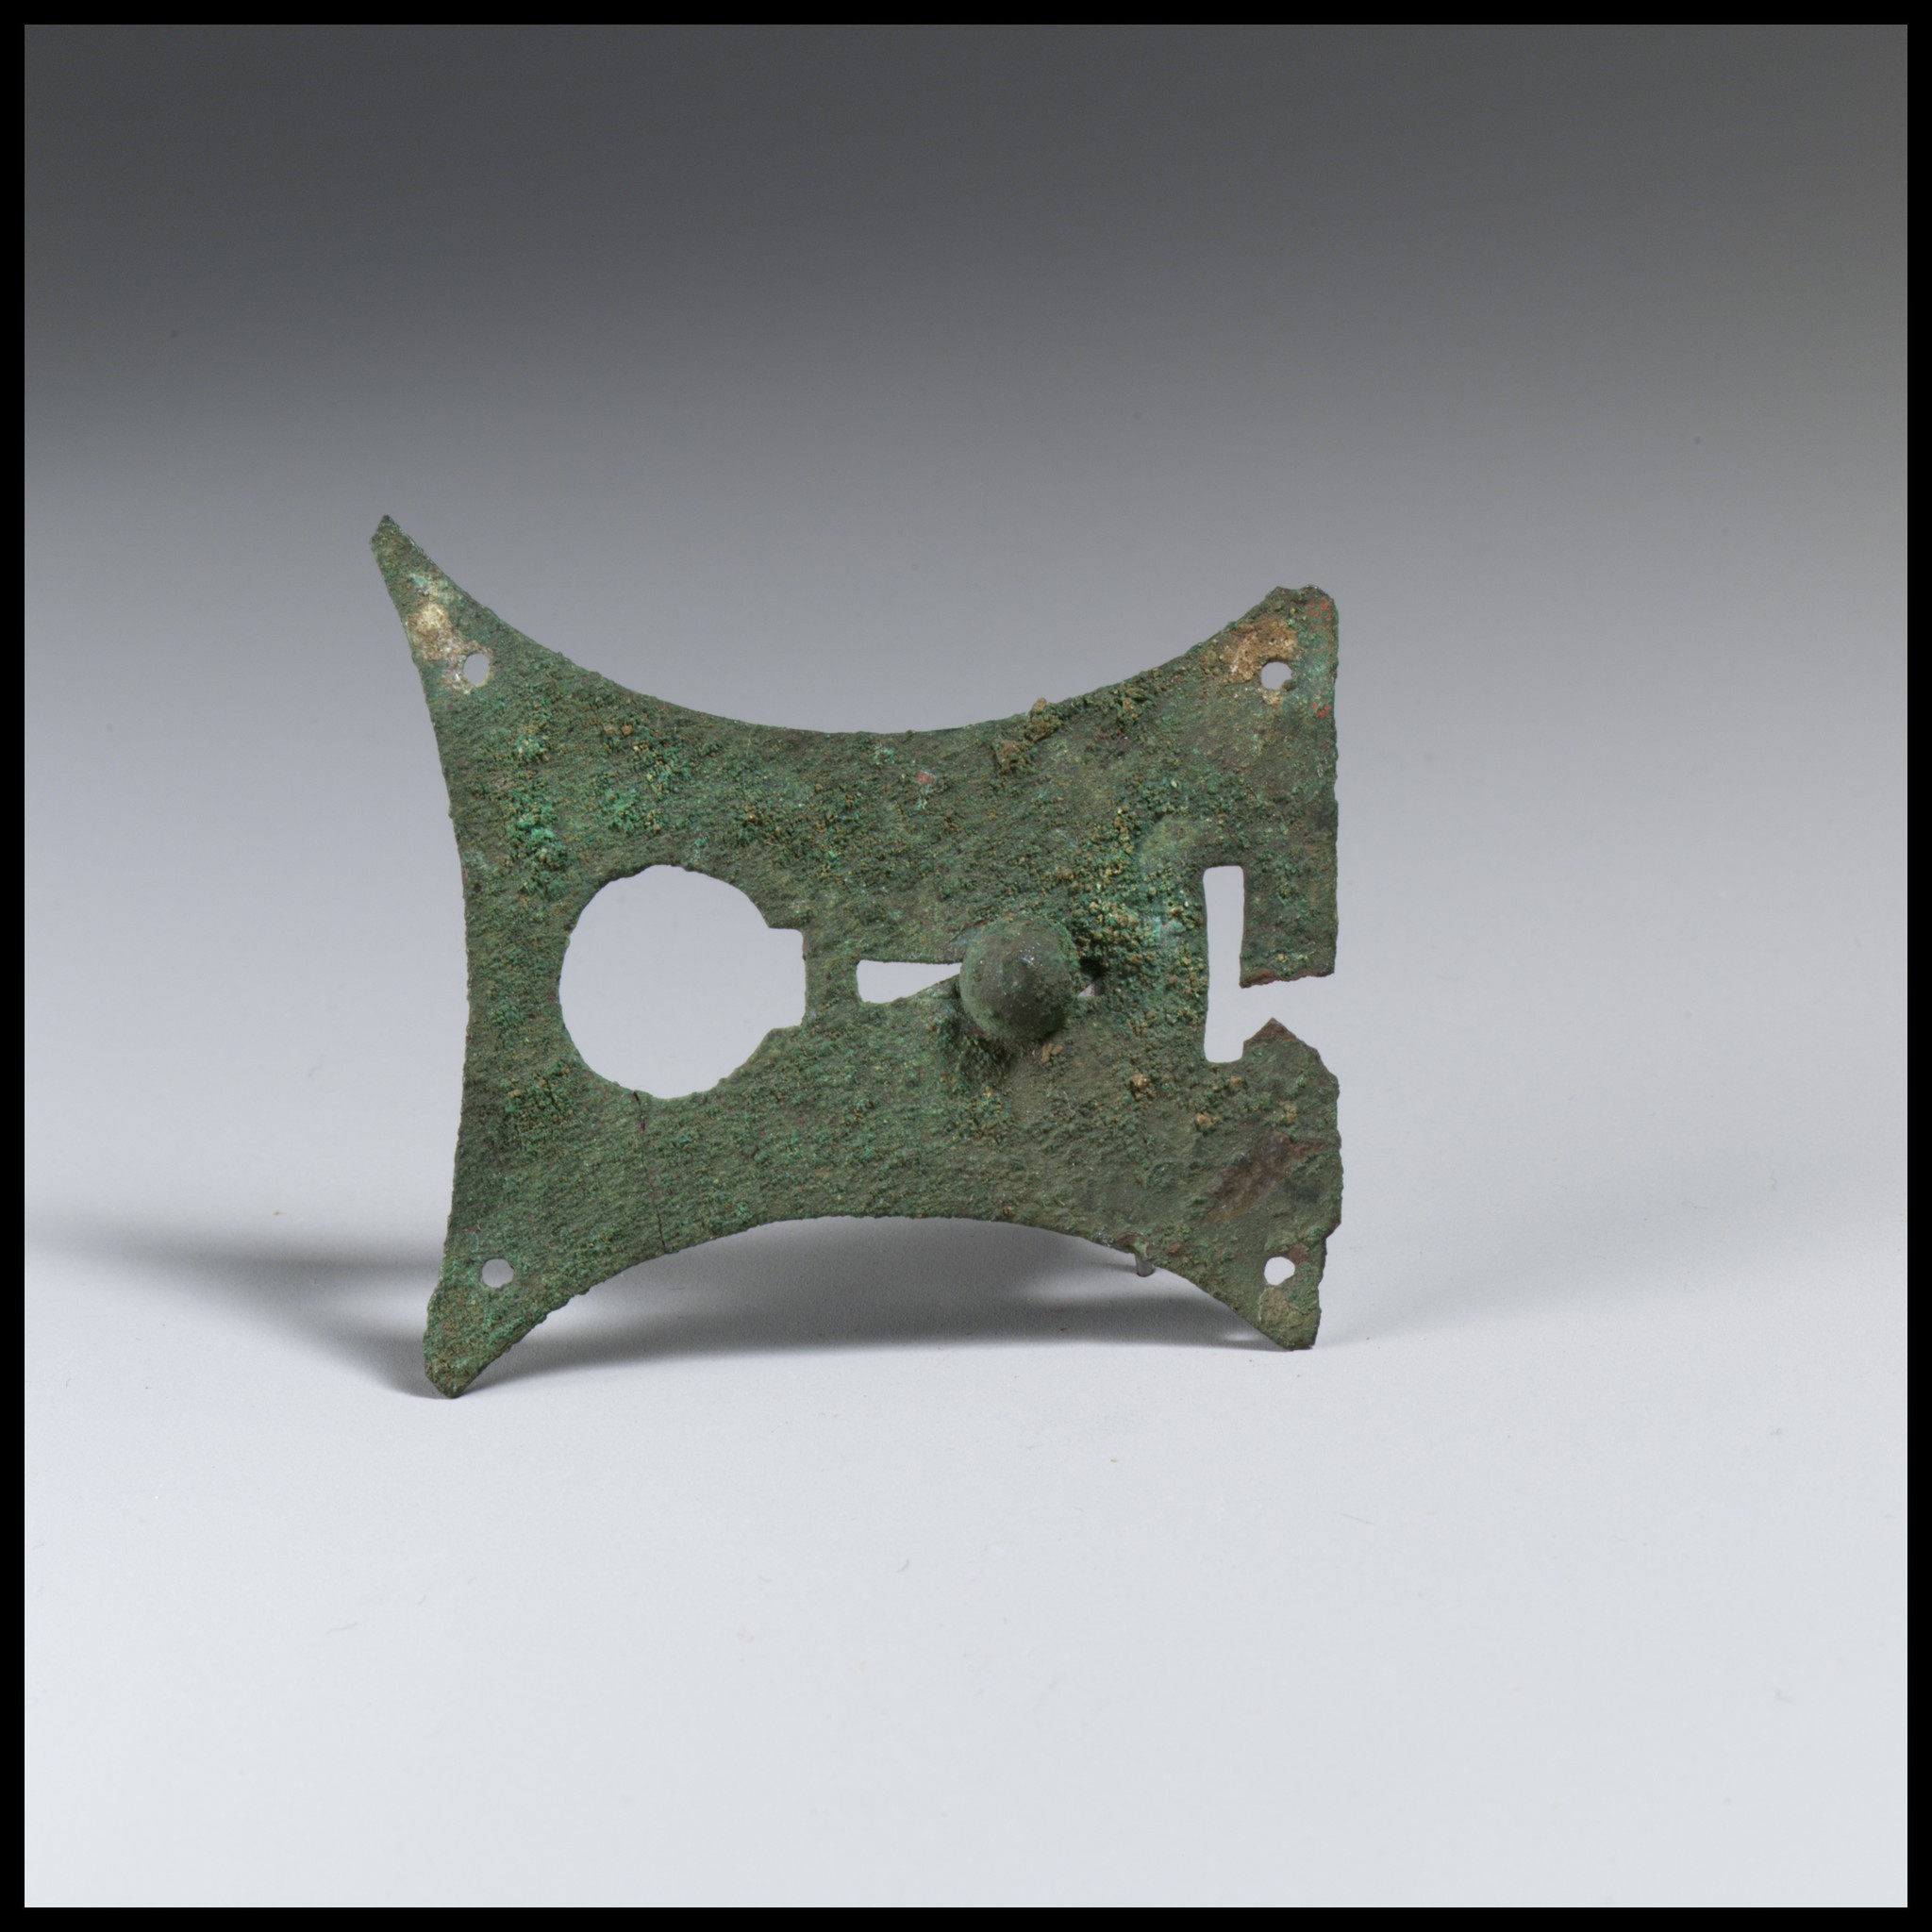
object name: lock plate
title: Lock-plate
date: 7000 BCE-330 CE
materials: bronze